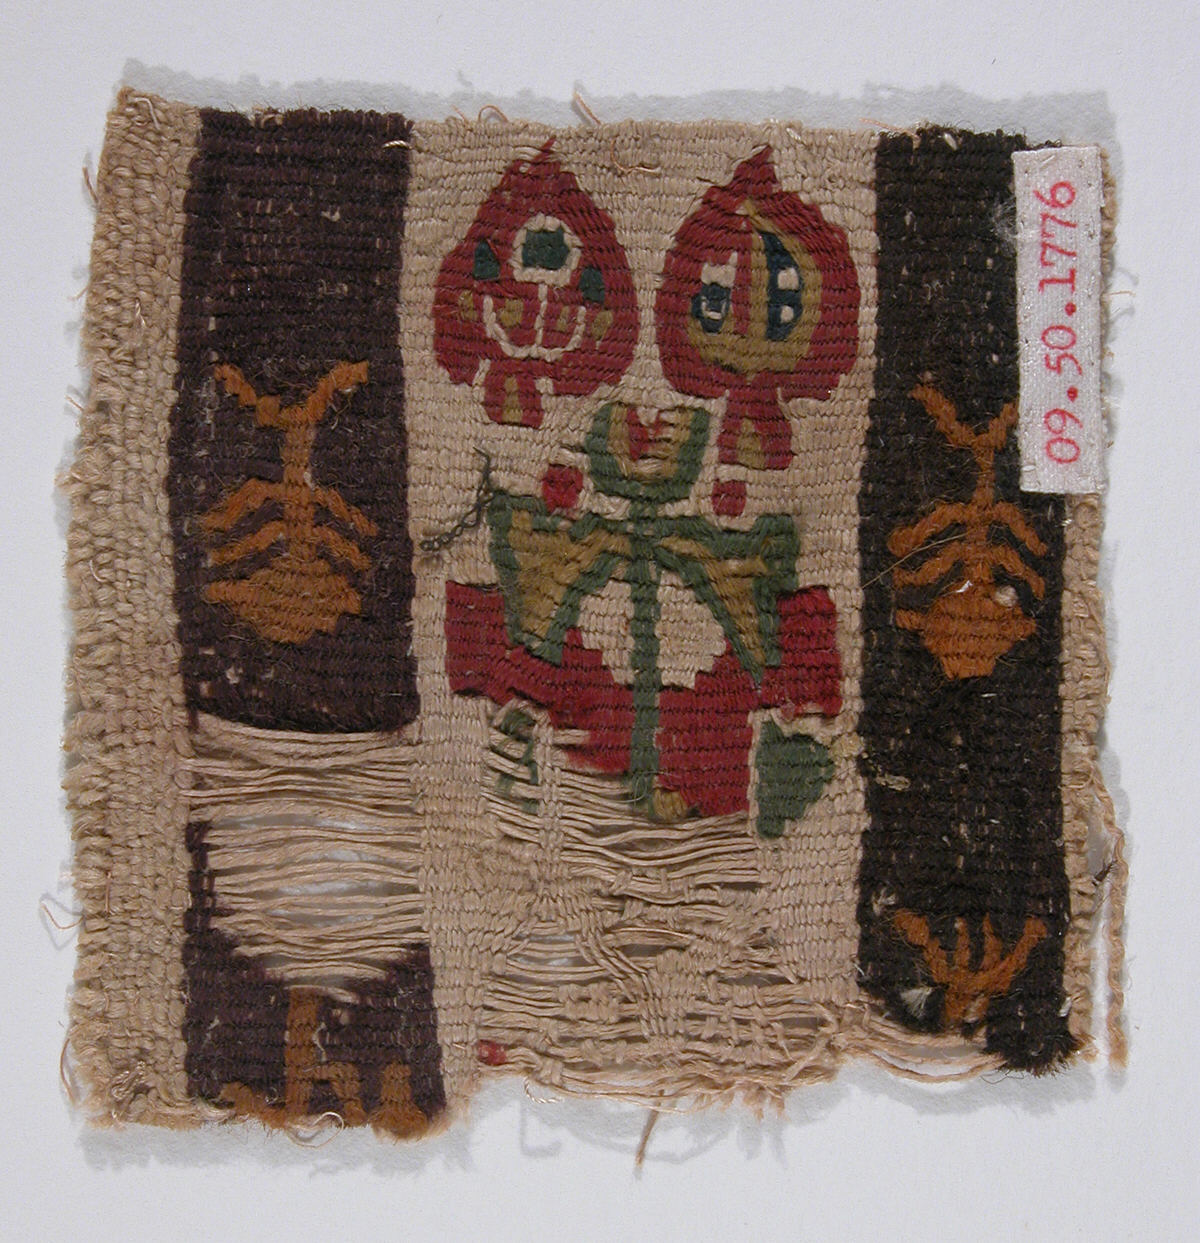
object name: band fragment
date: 401-600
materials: linen, wool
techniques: weave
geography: egypt